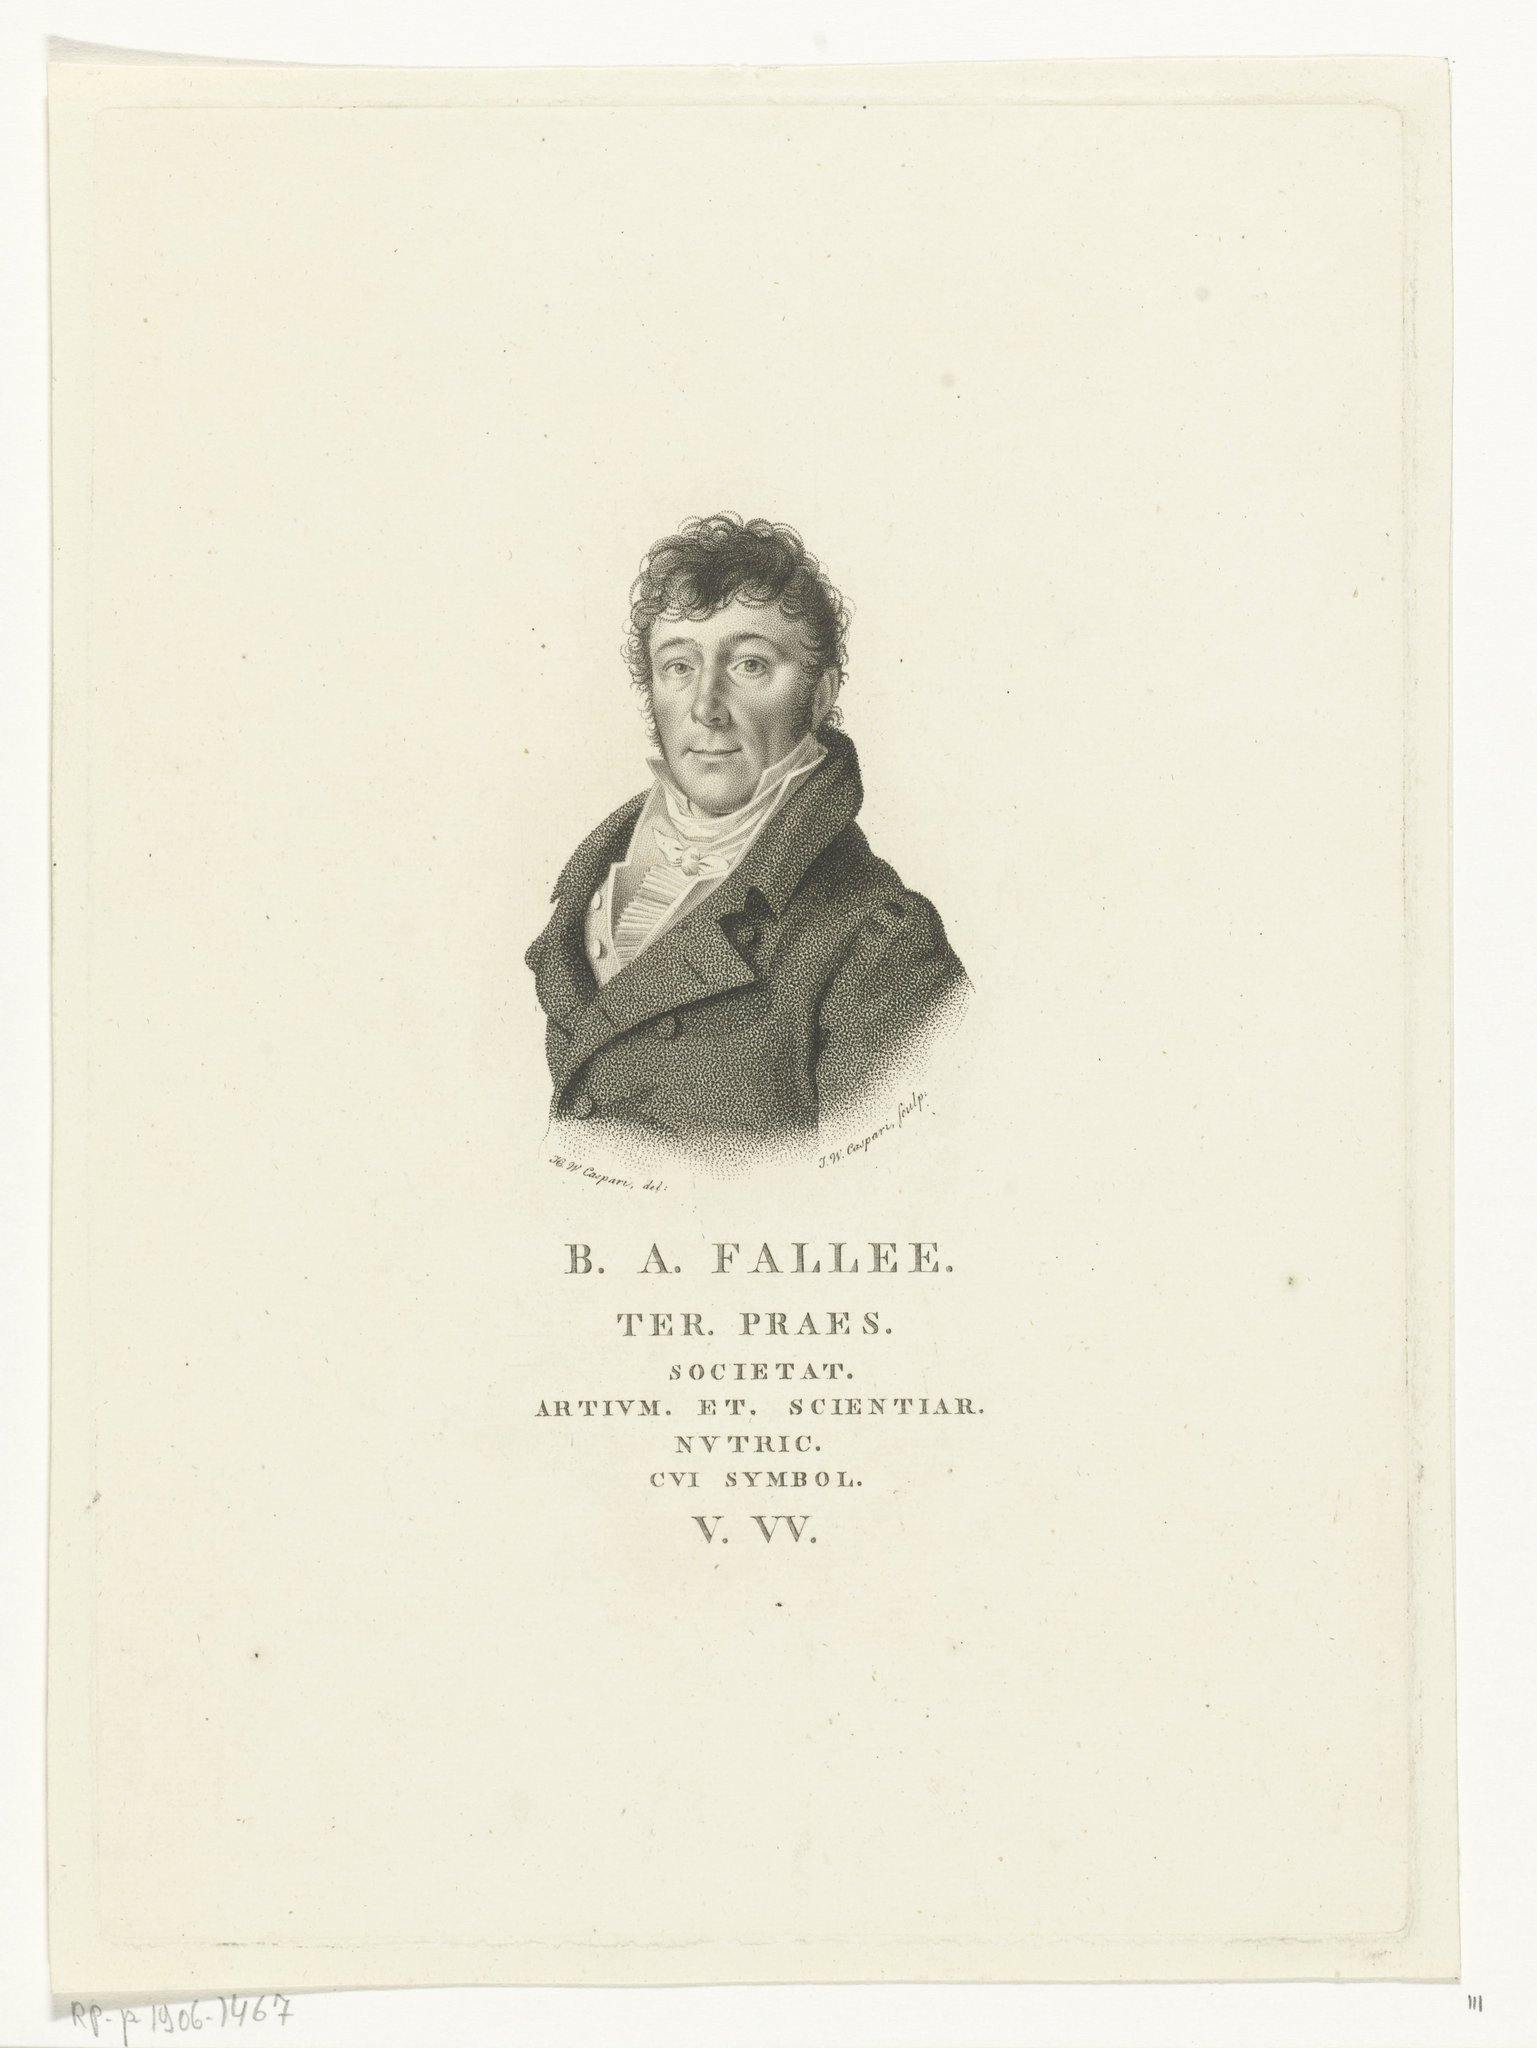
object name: print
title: Portret van Bernardus Antonius Fallee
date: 1789-1822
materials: paper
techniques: etching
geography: amsterdam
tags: the hague, bernard anthonie fallée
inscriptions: collector's mark: Lugt 2228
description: Portret van Bernardus Antonius Fallee, een Nederlandse toneelschrijver. Buste naar links. Fallee heeft een zwarte jas aan met een hoge kraag. De prent heeft een Latijns onderschrift met naam van de geportretteerde.